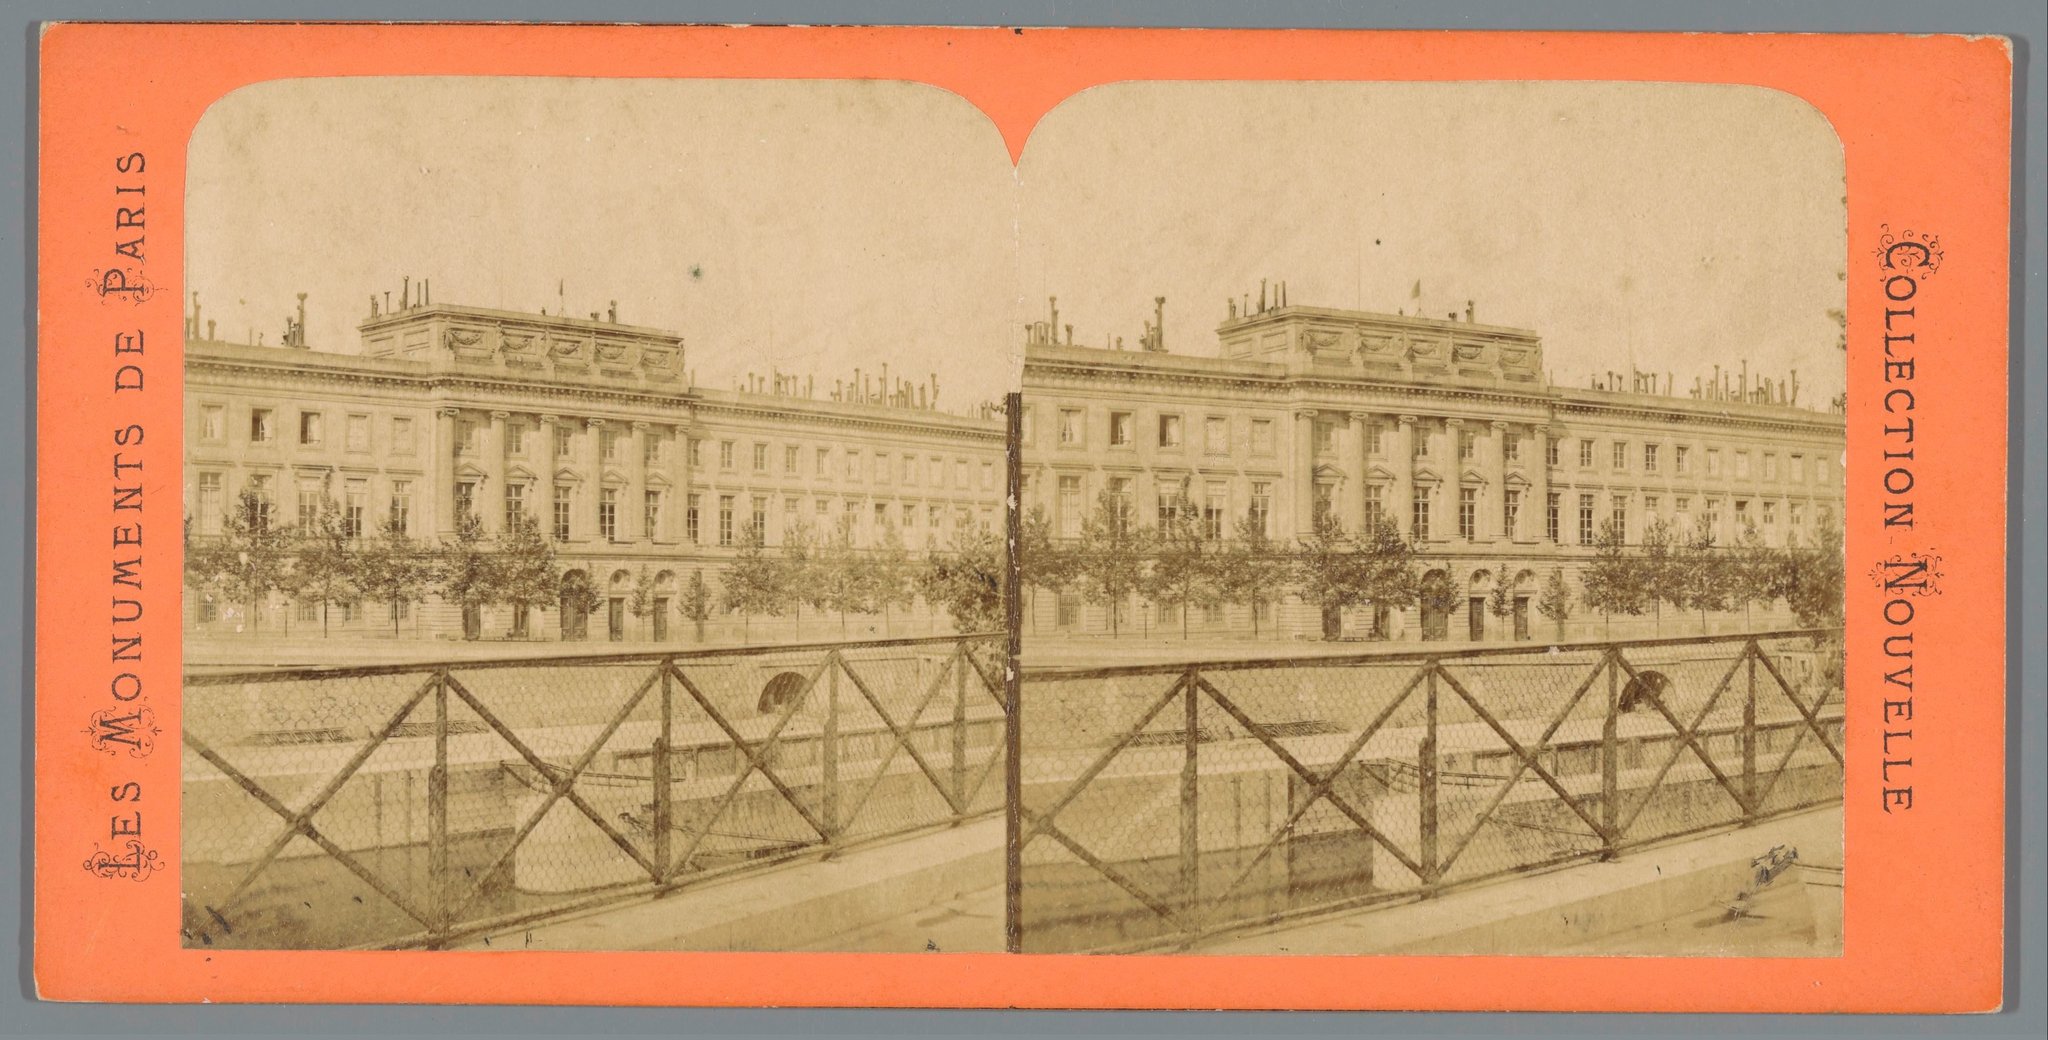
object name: stereograph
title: Les Monuments de Paris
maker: Anonymous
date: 1850-1880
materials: cardboard, photographic support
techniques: albumen print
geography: paris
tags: façade (of house or building), money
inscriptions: inscription: ‘La Monnaie’